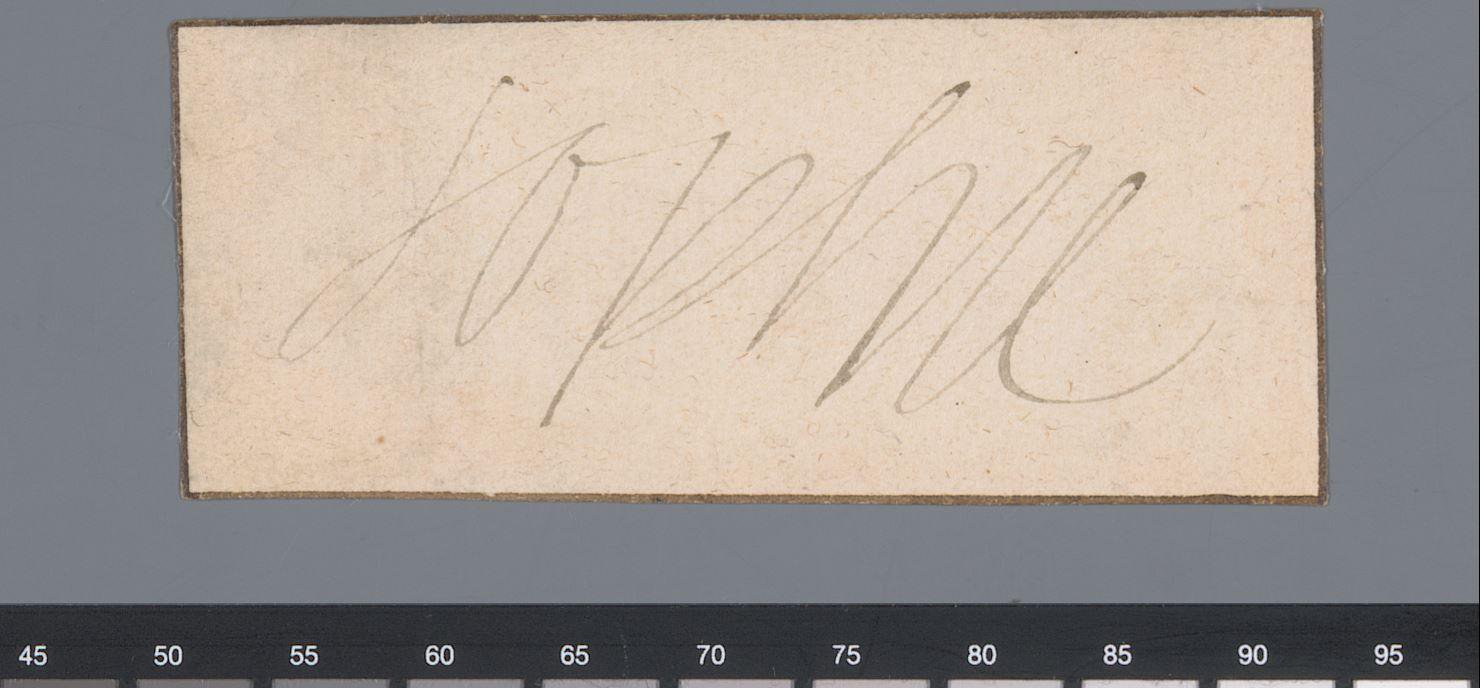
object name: paper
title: Document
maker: sophia hedwig van brunswijk-wolfenbüttel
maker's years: 159-1642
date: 1600-1650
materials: ink, paper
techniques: writing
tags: sophia hedwig van brunswijk-wolfenbüttel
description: Handtekening in bruine inkt (van Sophia Hedwig van Brunswijk), op blaadje papier. Gesigneerd: Sophie.